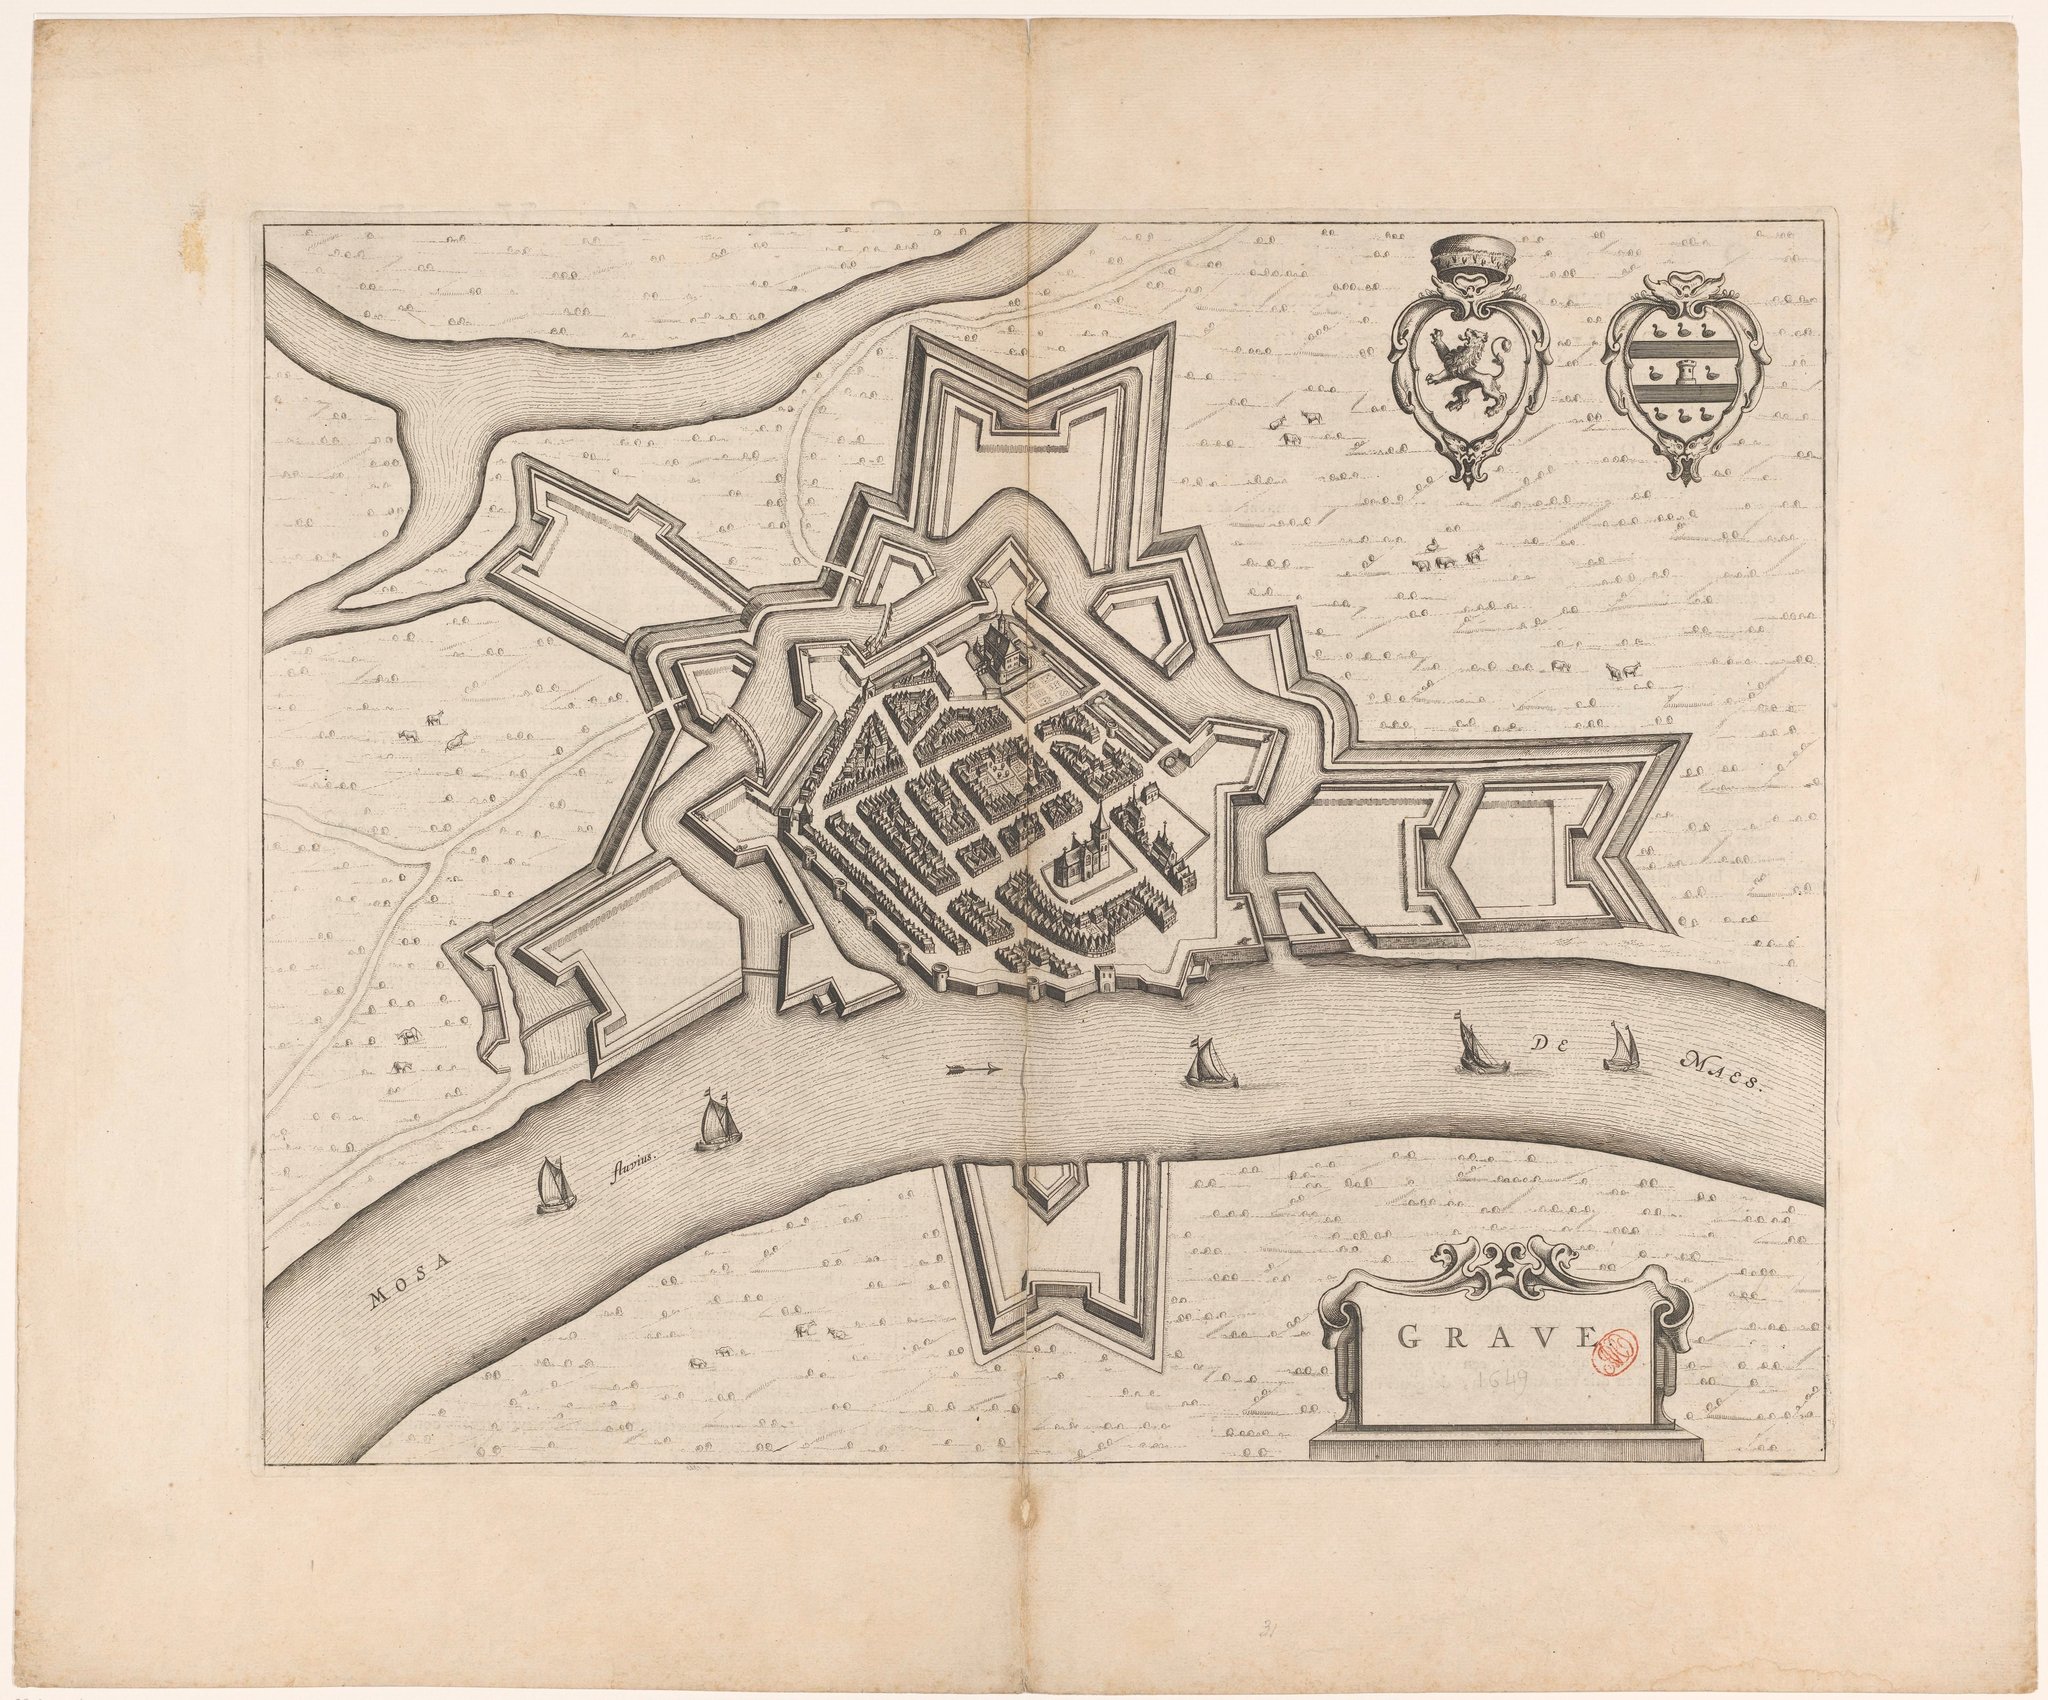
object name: area plan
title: Vestingplattegrond van Grave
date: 1652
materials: paper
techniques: engraving, etching, letterpress printing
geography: amsterdam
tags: coat of arms (as symbol of the state, etc.) (+ city; municipal), fortified city, maps of cities, coat of arms (as symbol of the state, etc.) (+ province; provincial), grave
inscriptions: collector's mark: Lugt 195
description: Vestingplattegrond van Grave in vogelvluchtperspectief. Rechtsonder de titelcartouche. Rechtsboven twee wapenschilden. Links het wapen van Brabant, rechts het wapen van Grave. Op verso Nederlandse tekst.